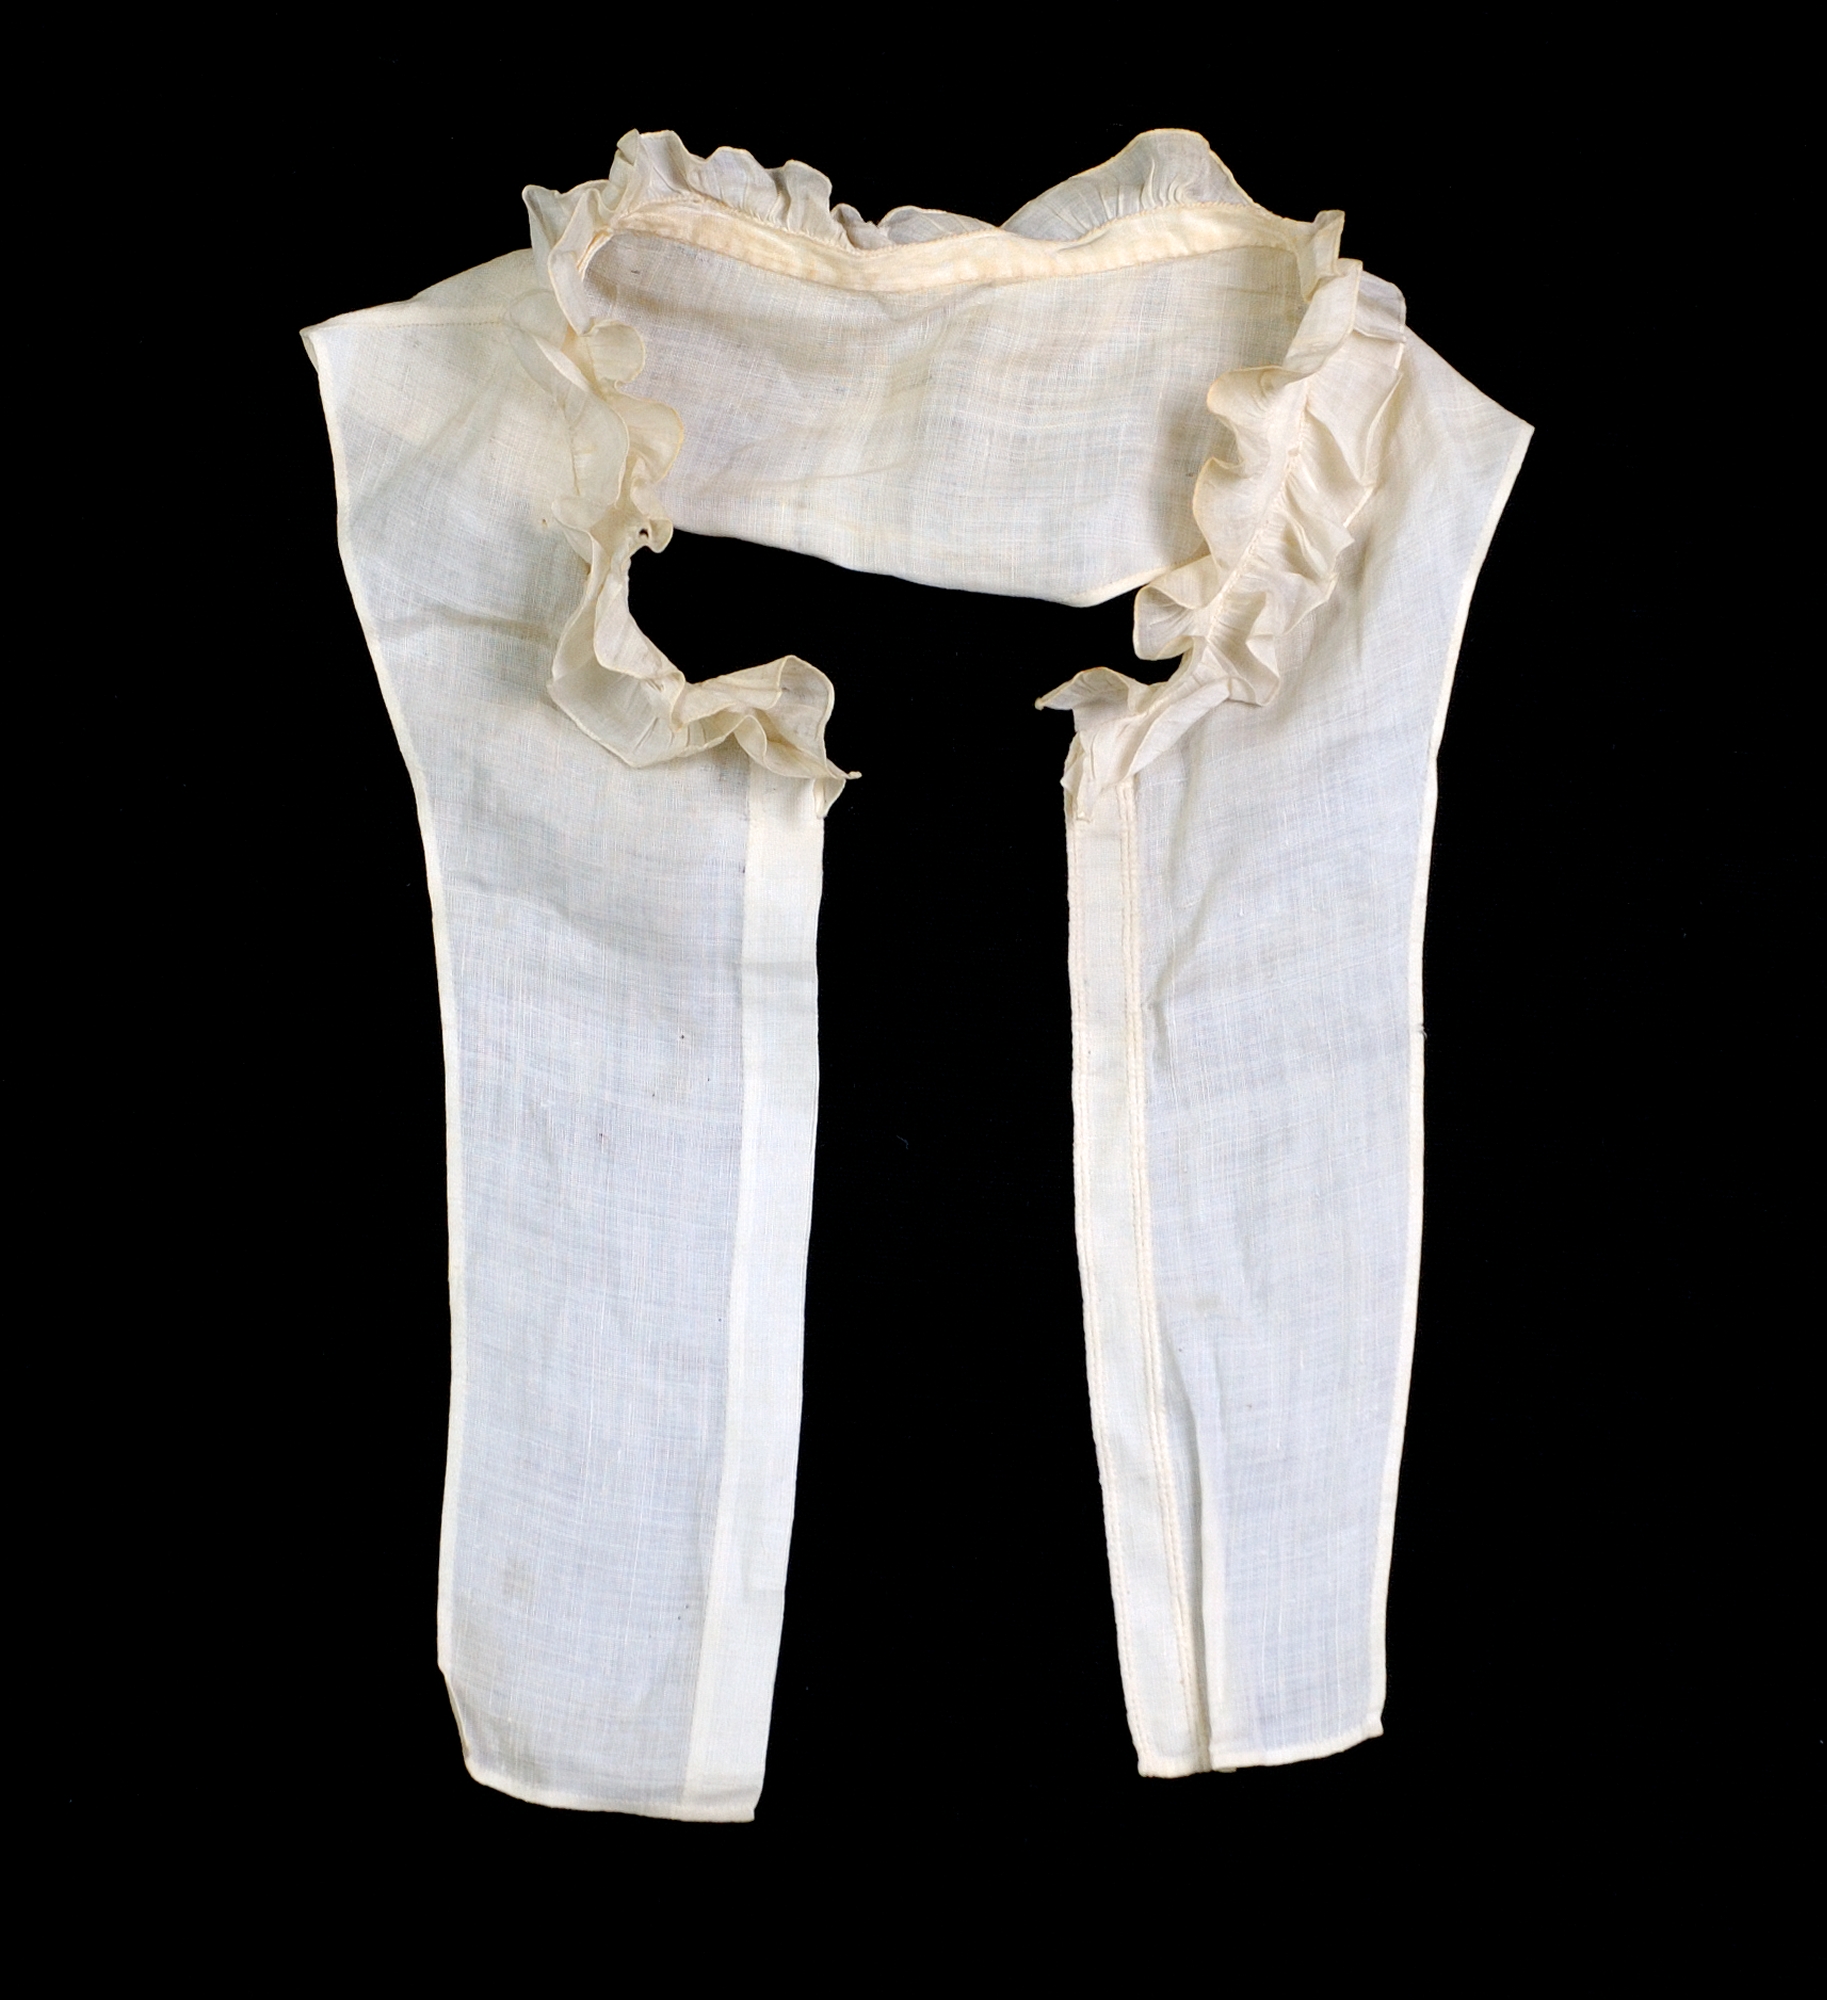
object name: collar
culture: american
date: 1840-1860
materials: cotton